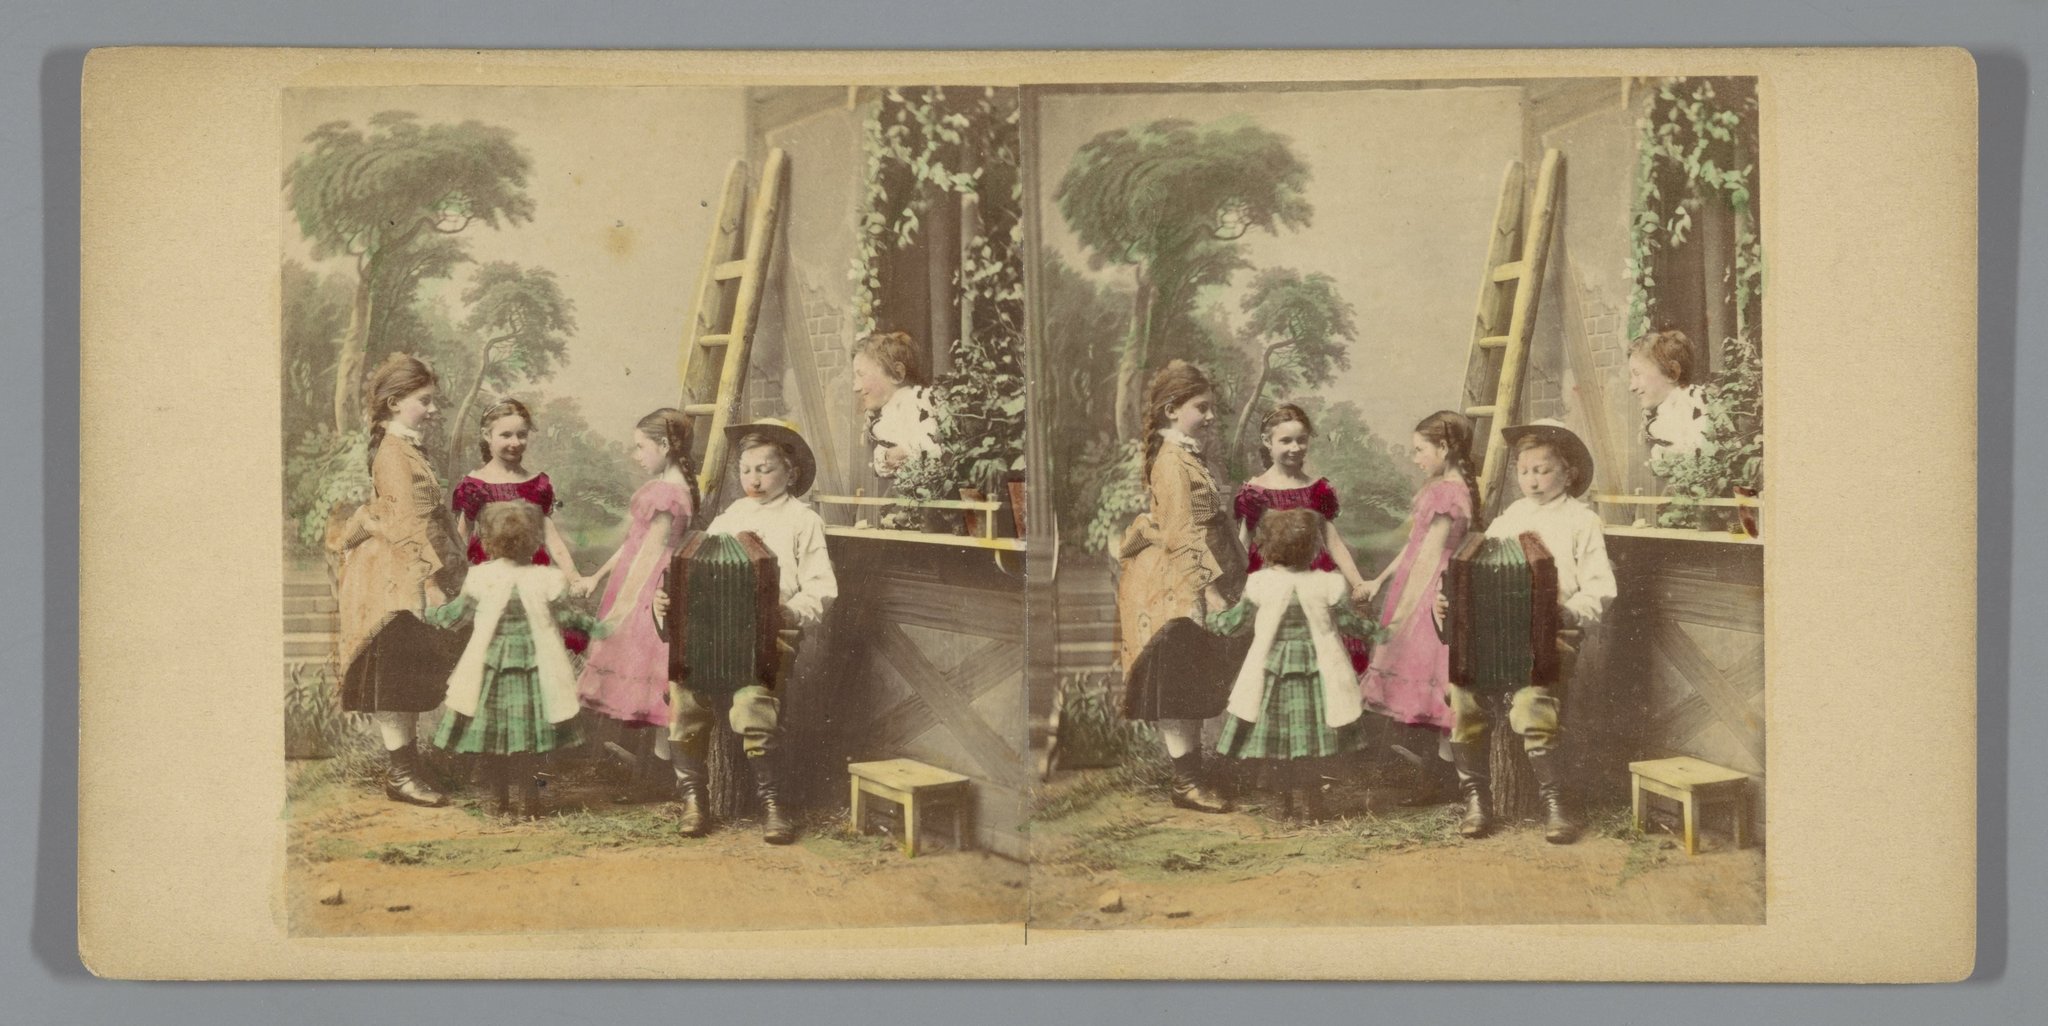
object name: stereograph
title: Musicerende en spelende kinderen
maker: Anonymous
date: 1857-1863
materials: cardboard, paper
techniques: albumen print, hand coloring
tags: making music; musician with instrument, child (at home)